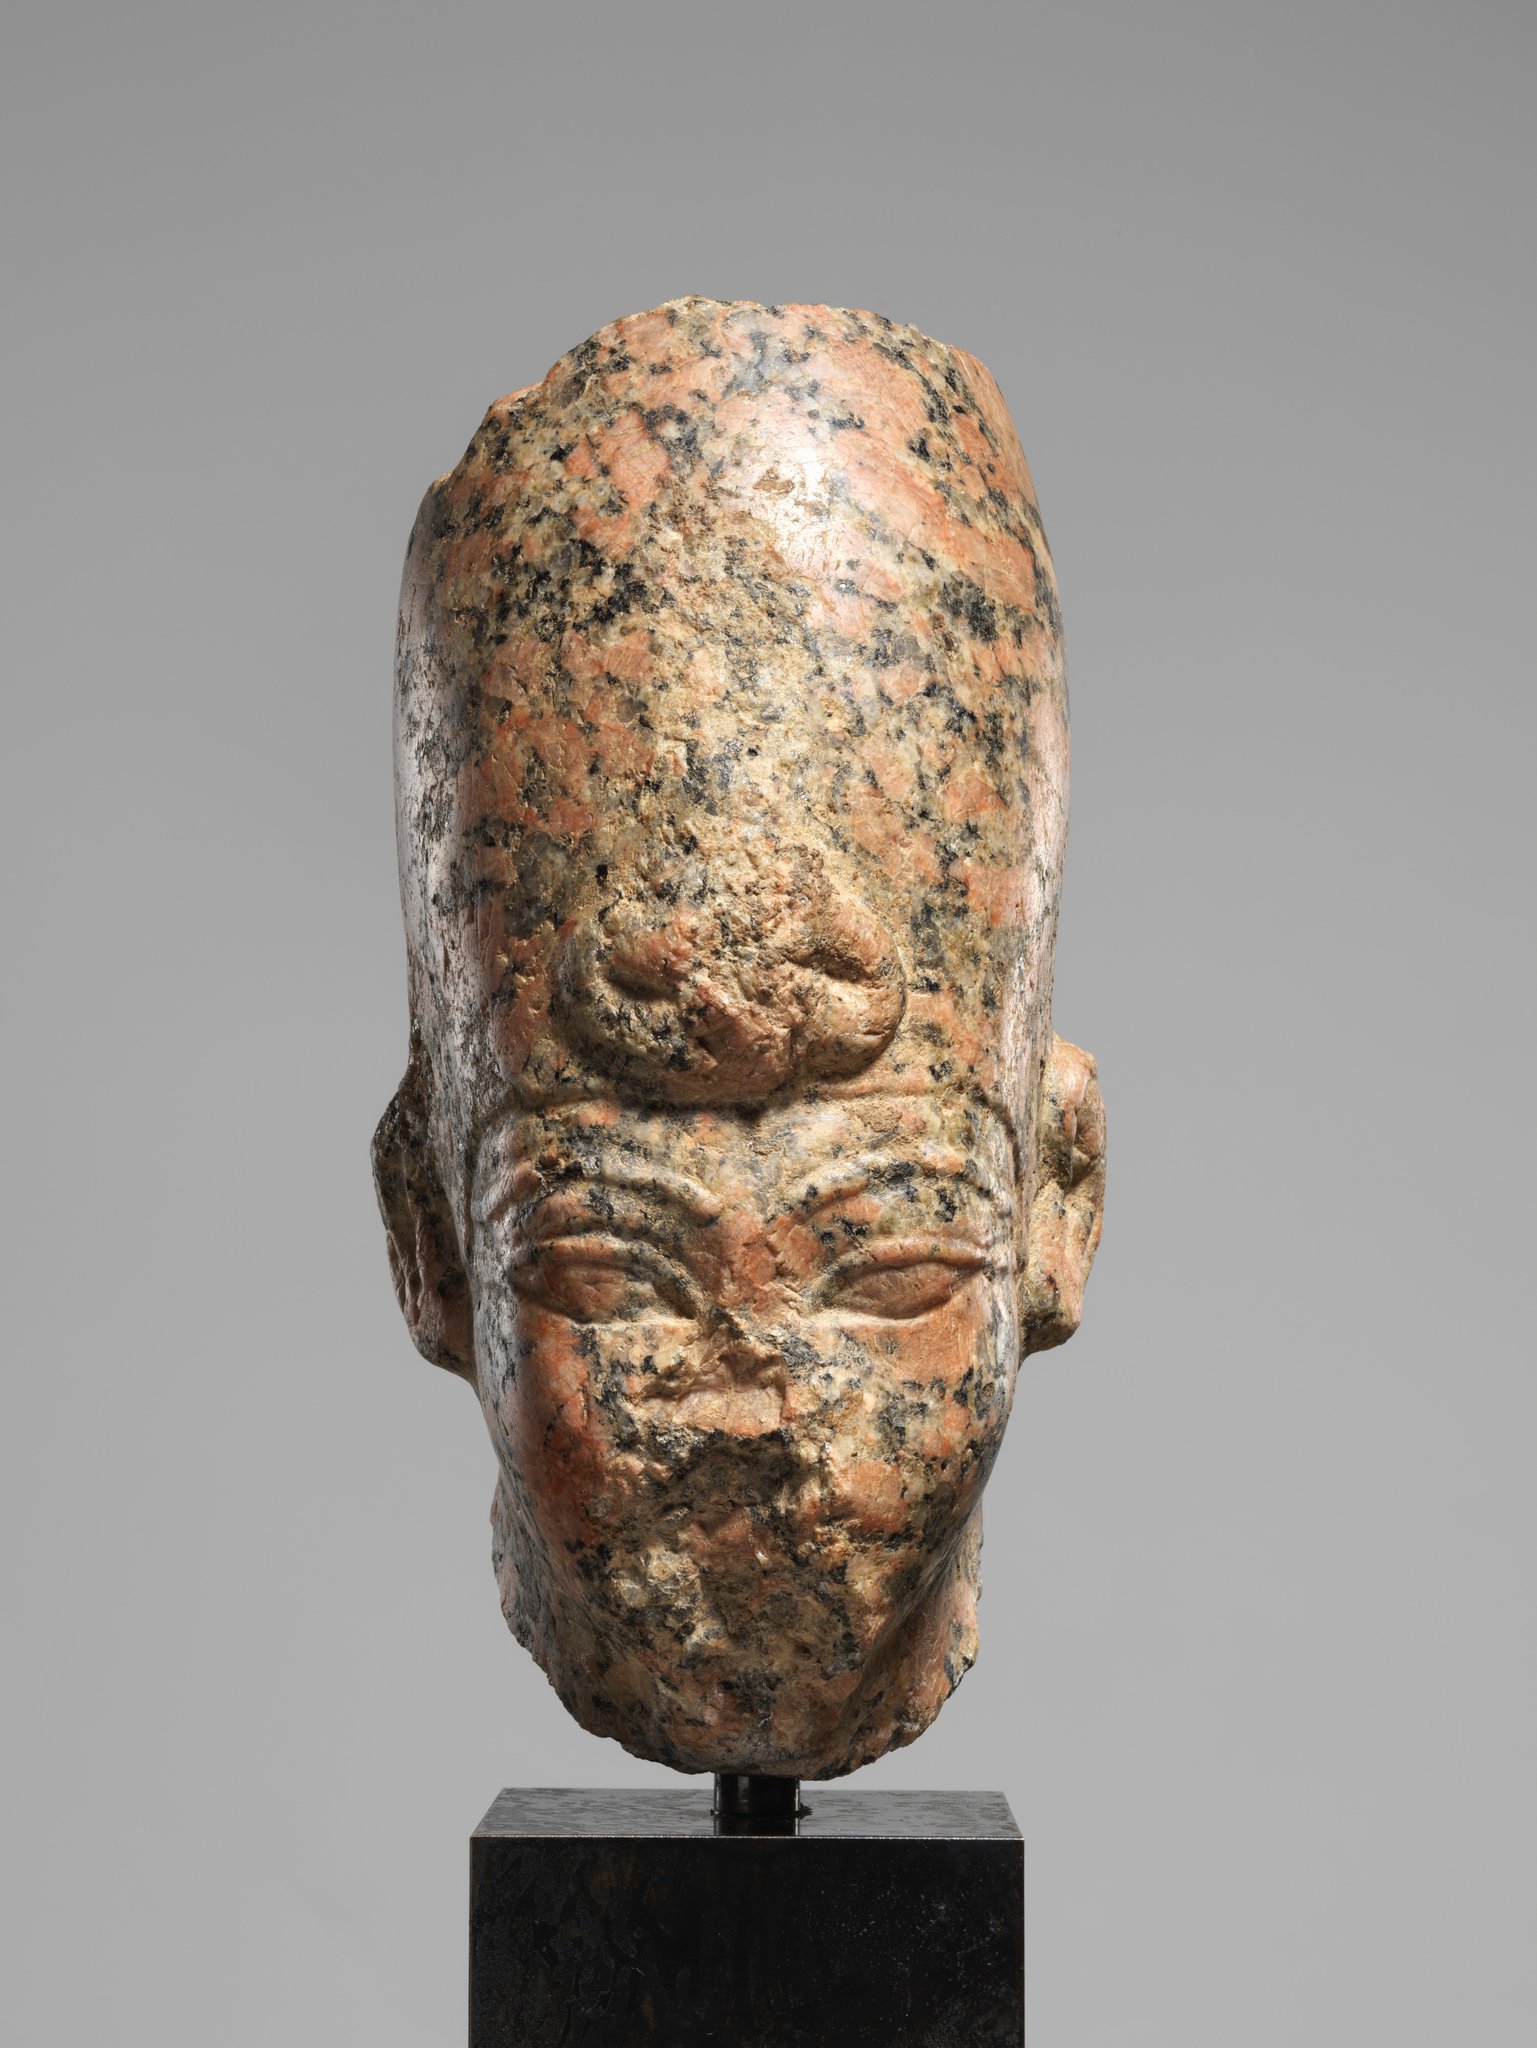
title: Head of Amenhotep III Wearing the White Crown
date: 1390-1352 BCE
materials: granite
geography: egypt